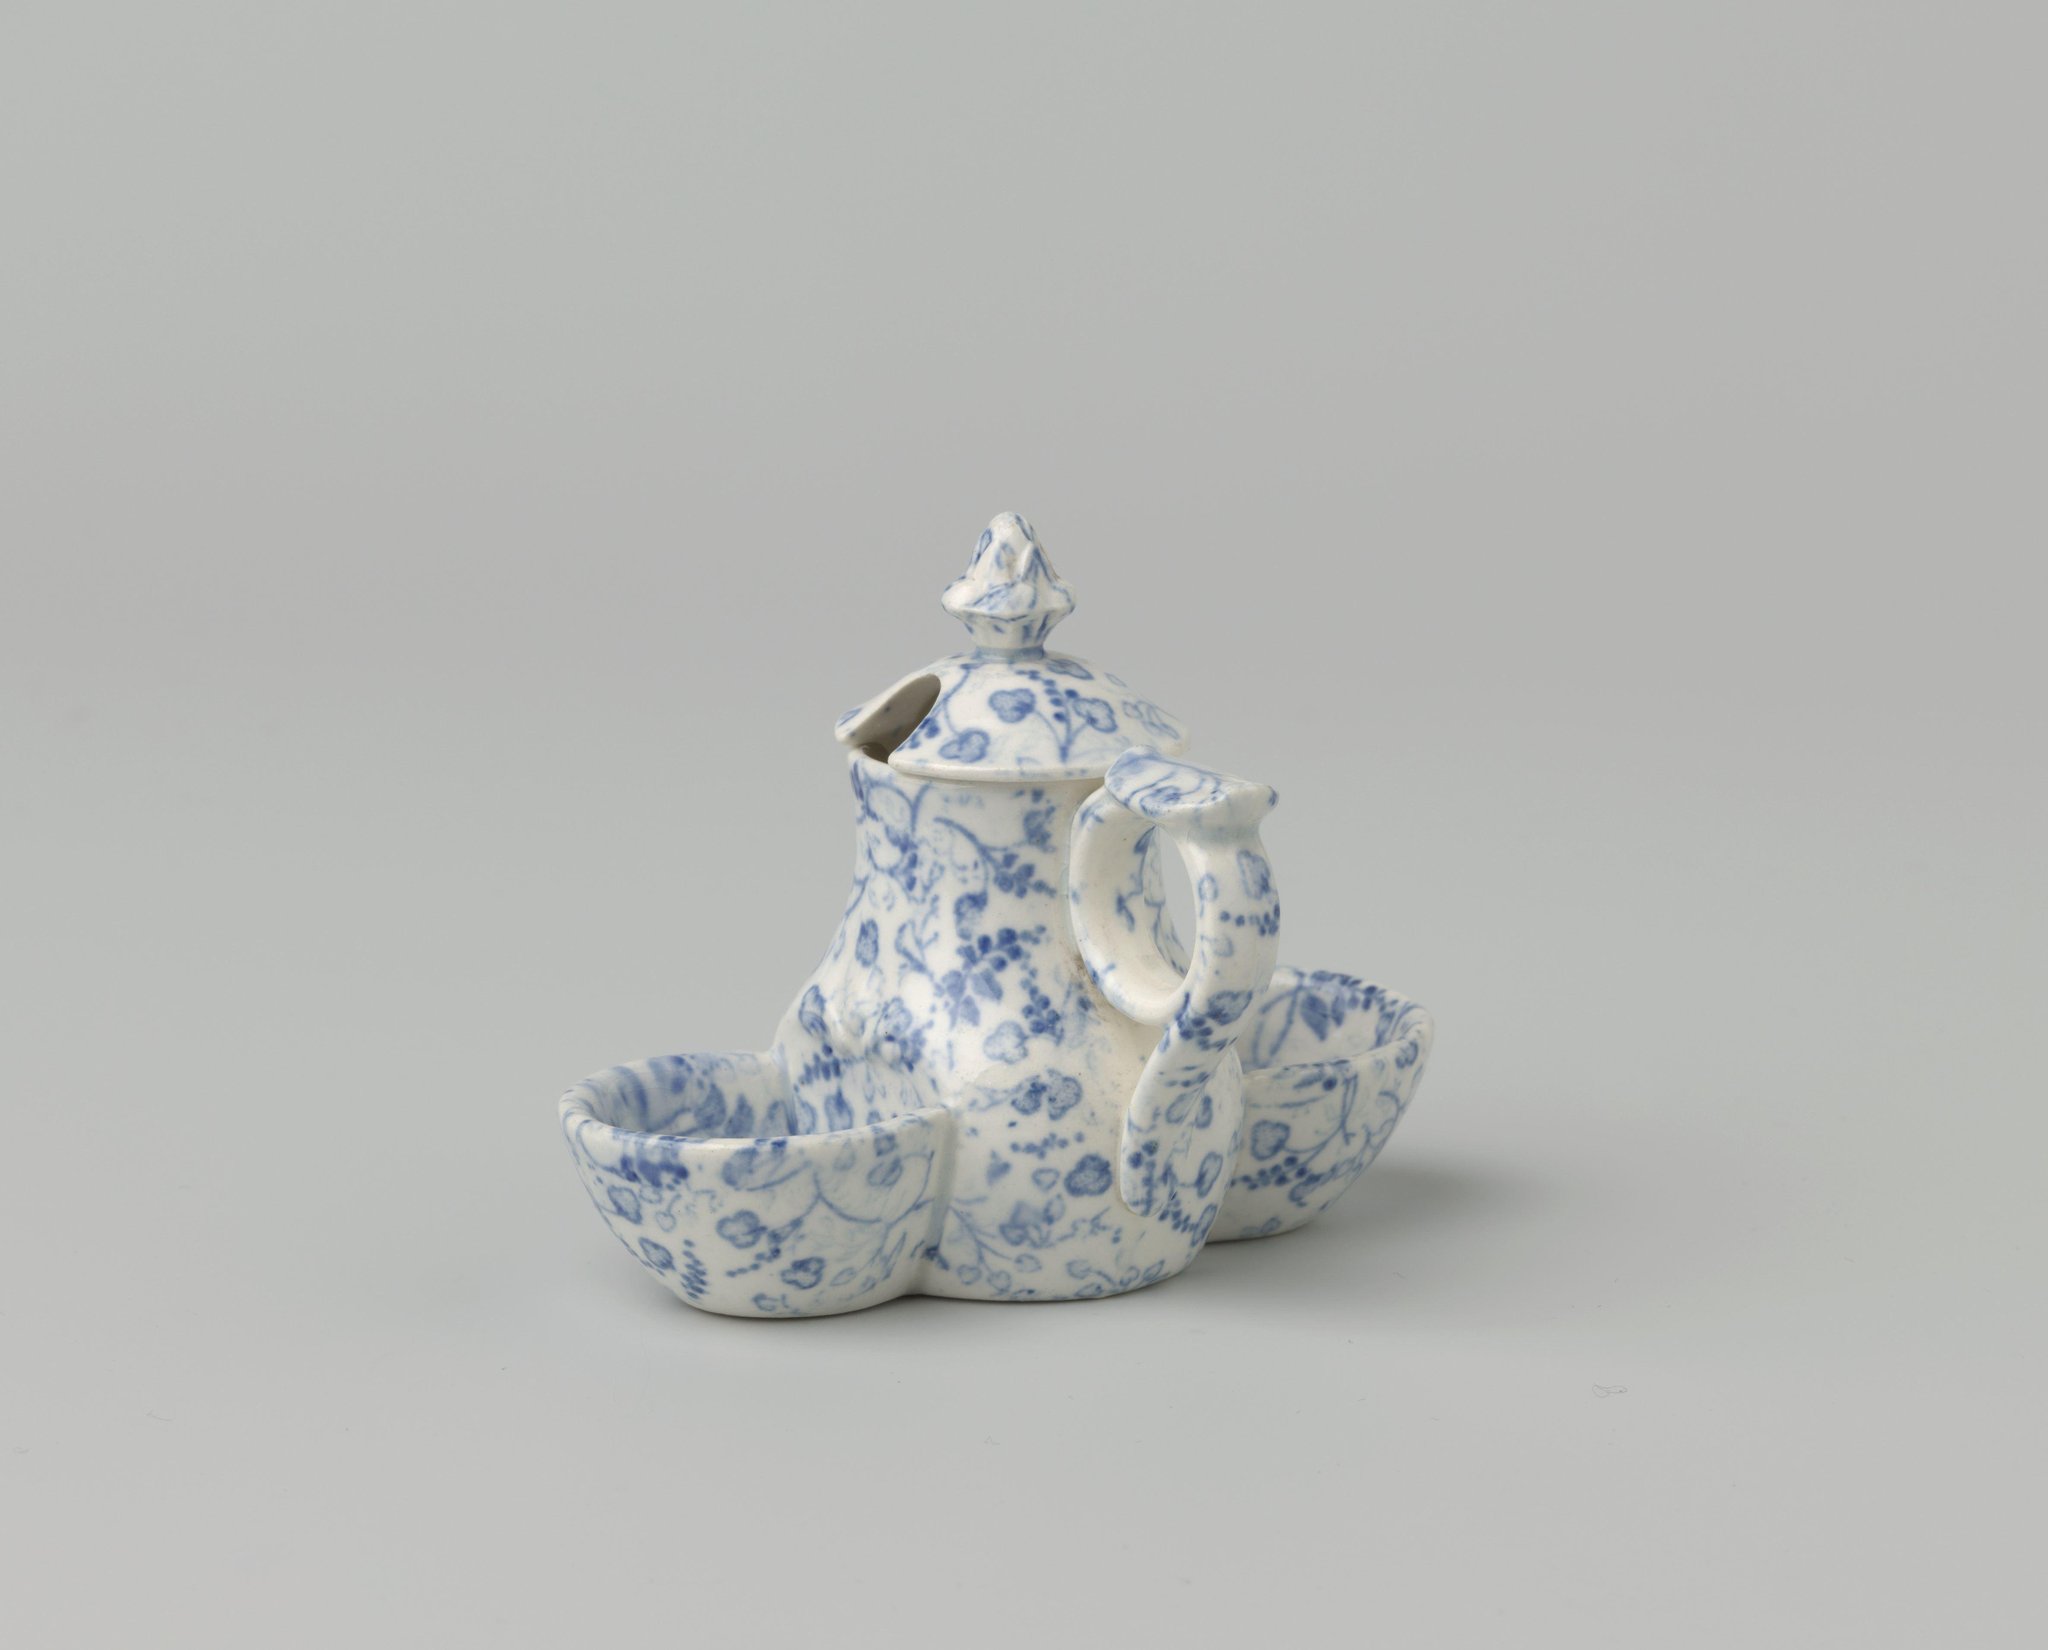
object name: kinderservies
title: Deksel van trois usages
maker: petrus regout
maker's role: plateelbakker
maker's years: 1801-1879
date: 1867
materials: creamware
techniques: transfer decoration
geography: maastricht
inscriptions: check stamp: ‘33’, check stamp: ‘PR // 31 (?)’, mark: ‘PARSEME No 3’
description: Deksel van trois usages van aardewerk met blauw doorlopend bloemendecor, behorend tot een kinderservies. Het ronde, gewelfde deksel heeft een opening voor een lepel en wordt bekroond door een bloemvormige knop.